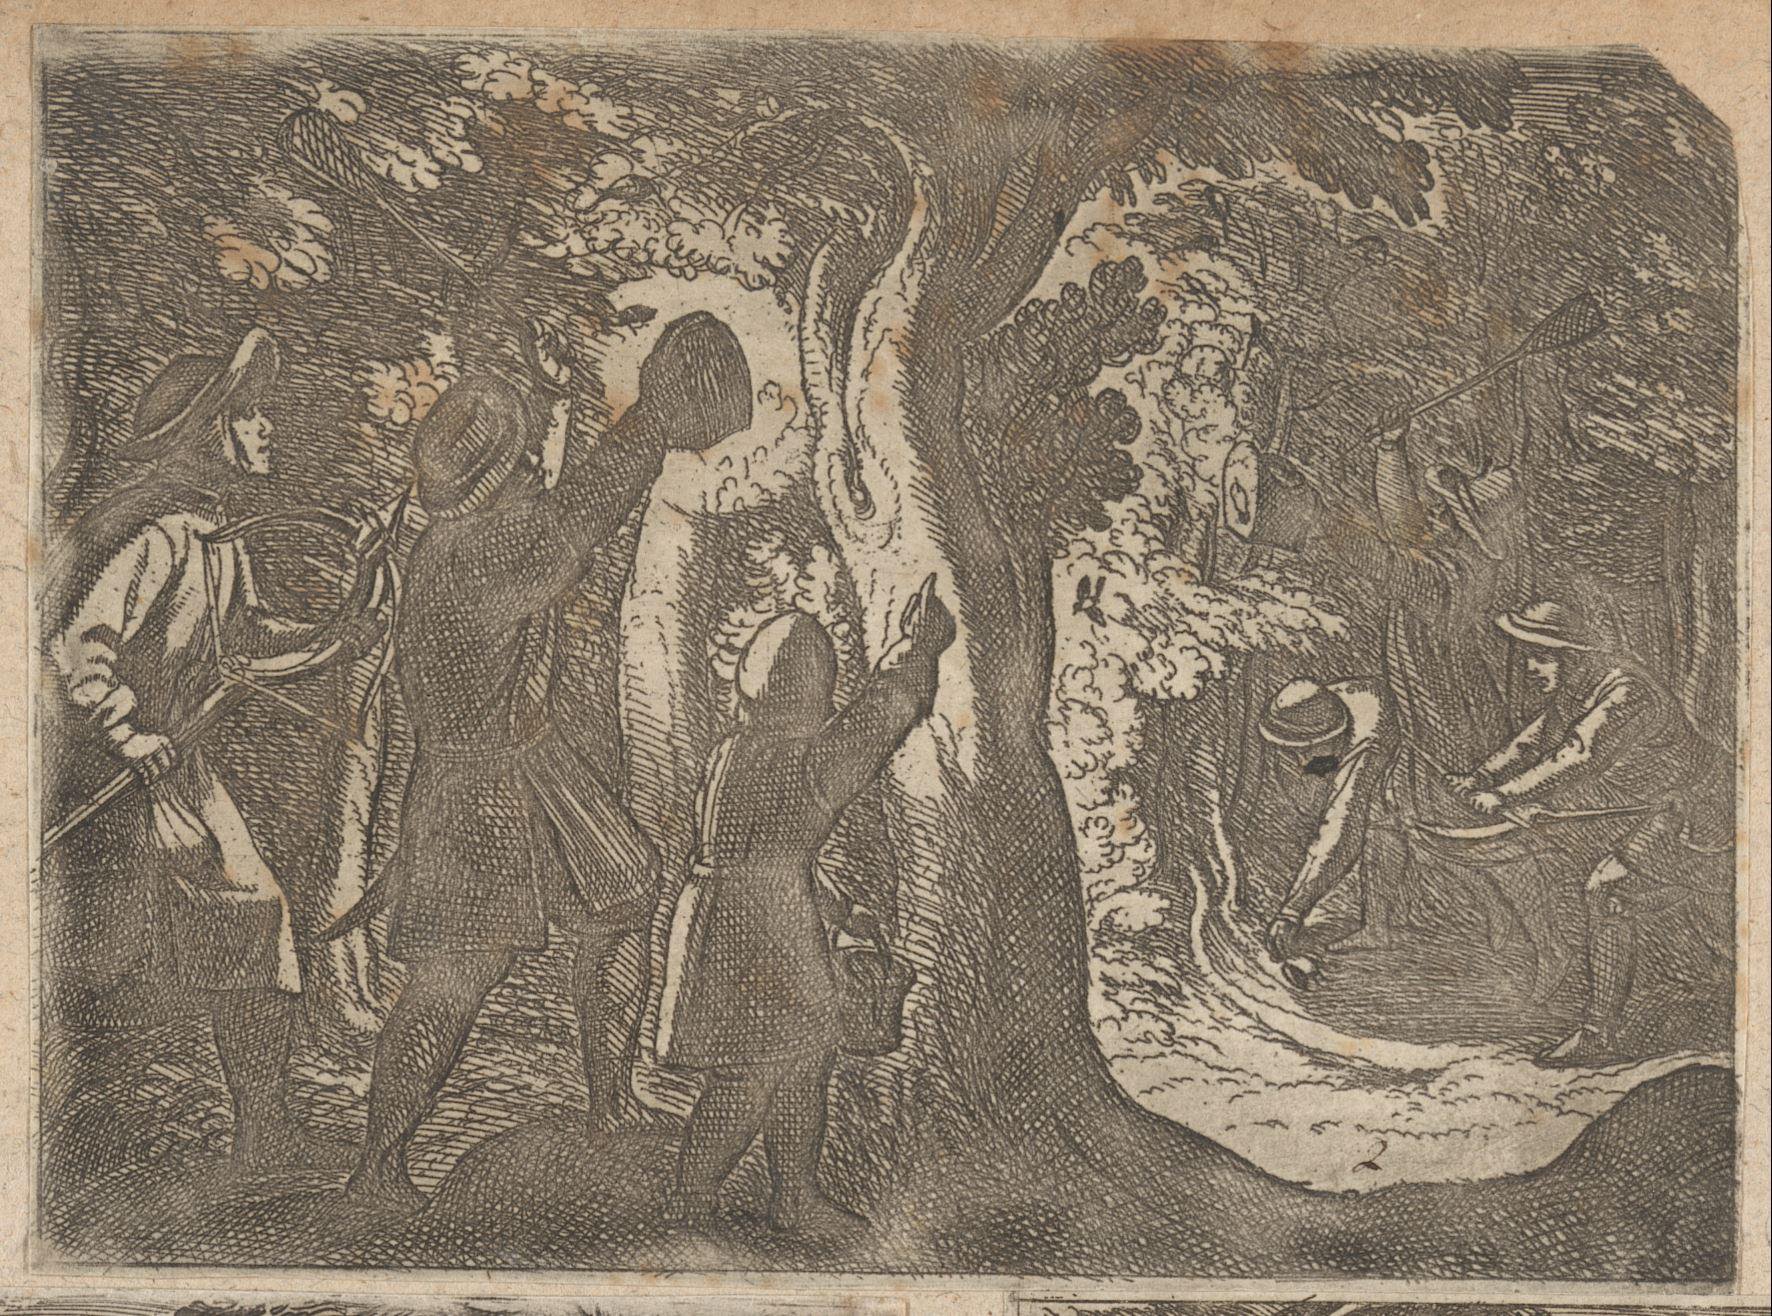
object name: print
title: Jagers vangen 's nachts vogels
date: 1598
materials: paper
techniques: etching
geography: italy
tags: hunter, hunters hunting (n.b.: in 1988-1990 this notation denoted the concept of 43c11421 'hunters resting during the hunt'), bird hunting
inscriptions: collector's mark: ‘Hinloopen’, number: ‘2’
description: Deze prent maakt deel uit van een reeks van 45 jachtscènes (+ titelprent en opdracht).